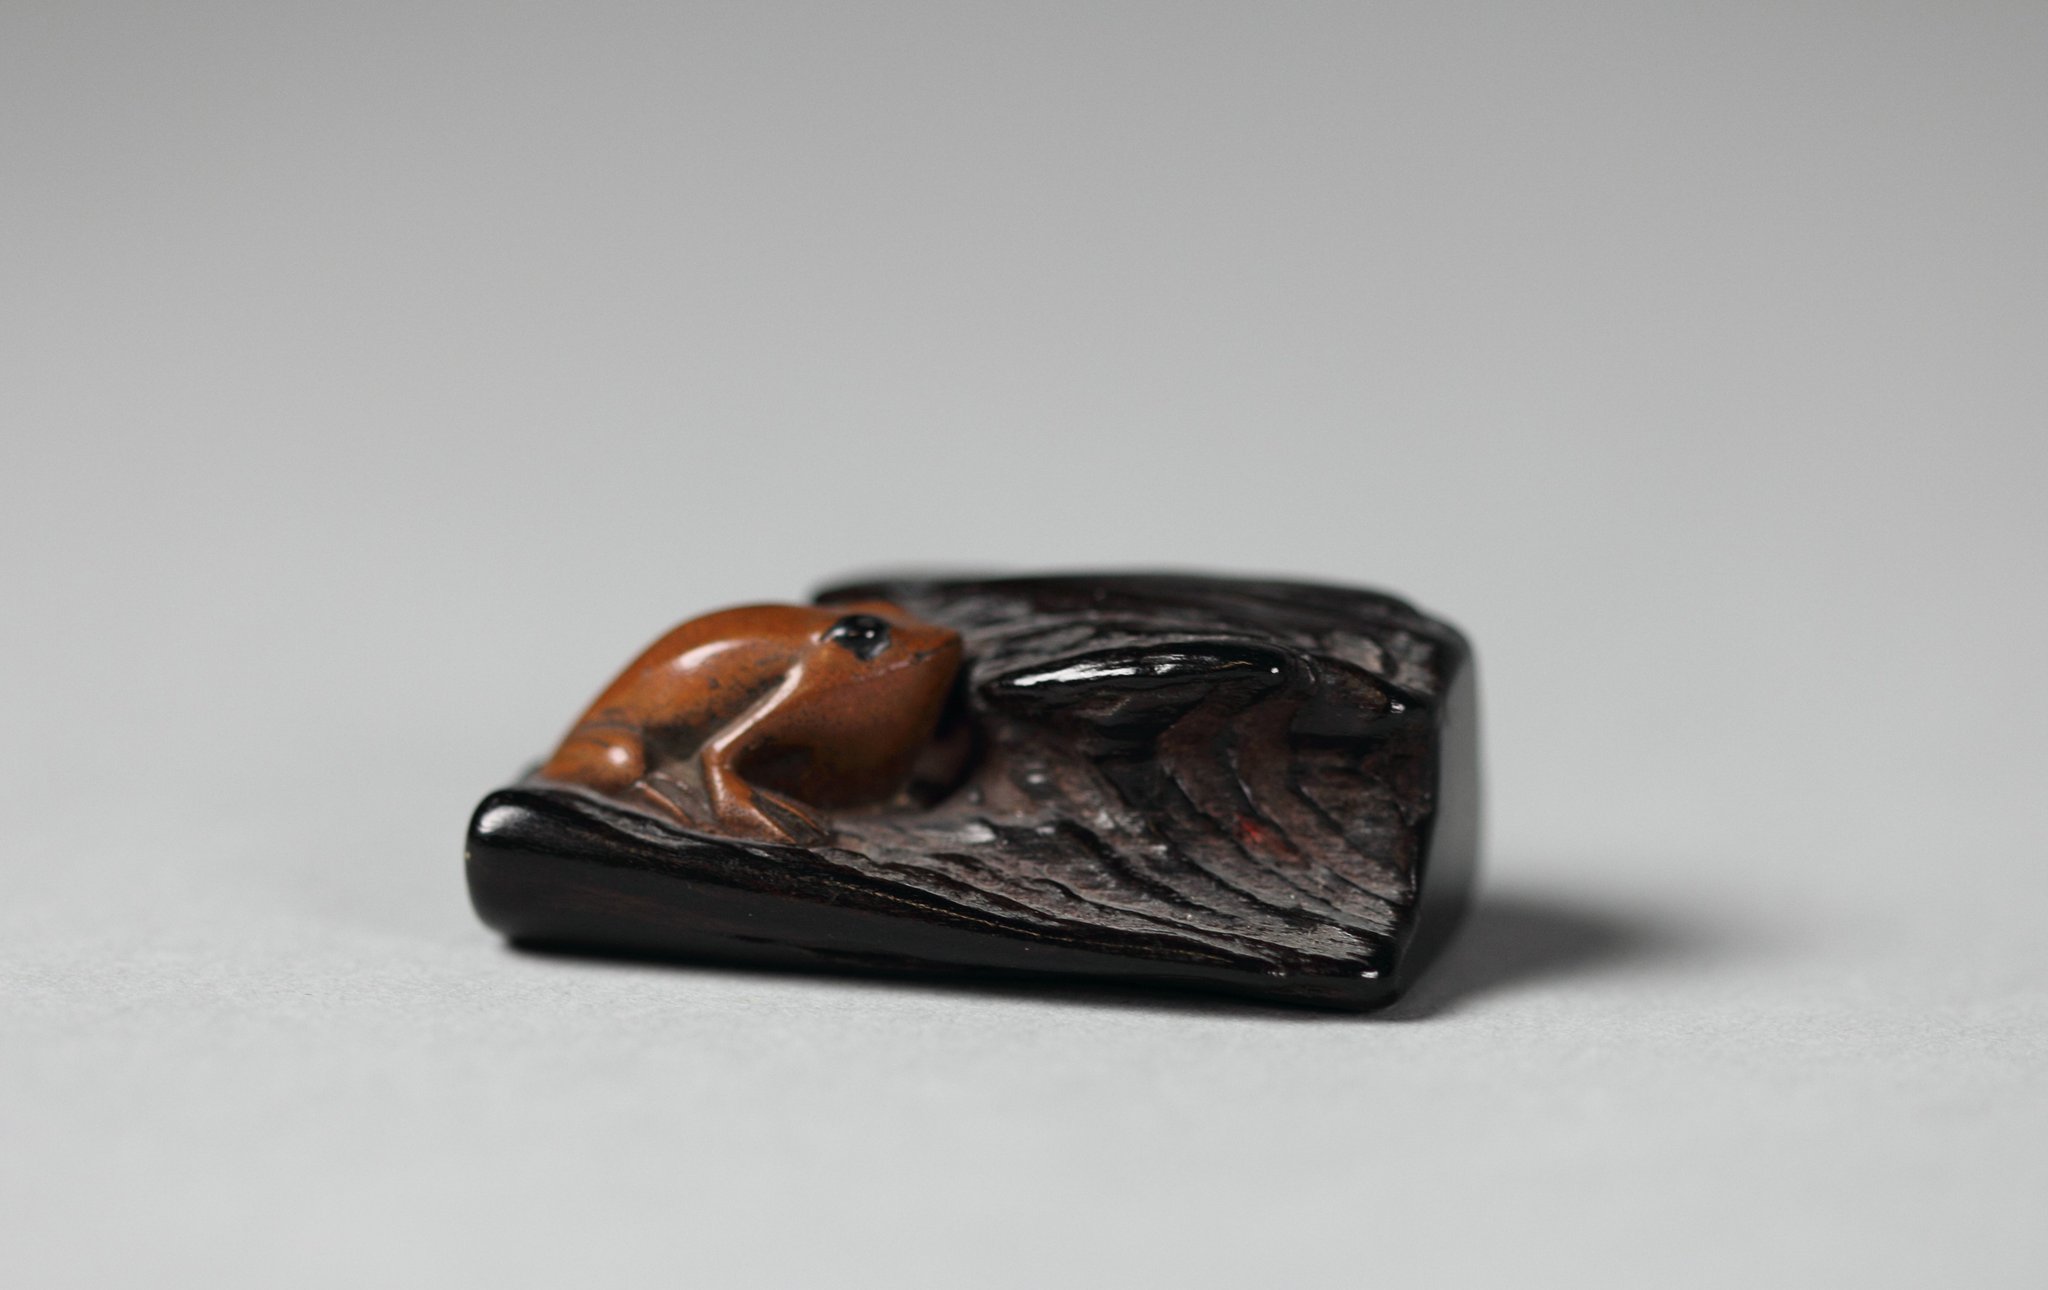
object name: netsuke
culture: japanese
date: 1801-1900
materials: bronze, wood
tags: frogs